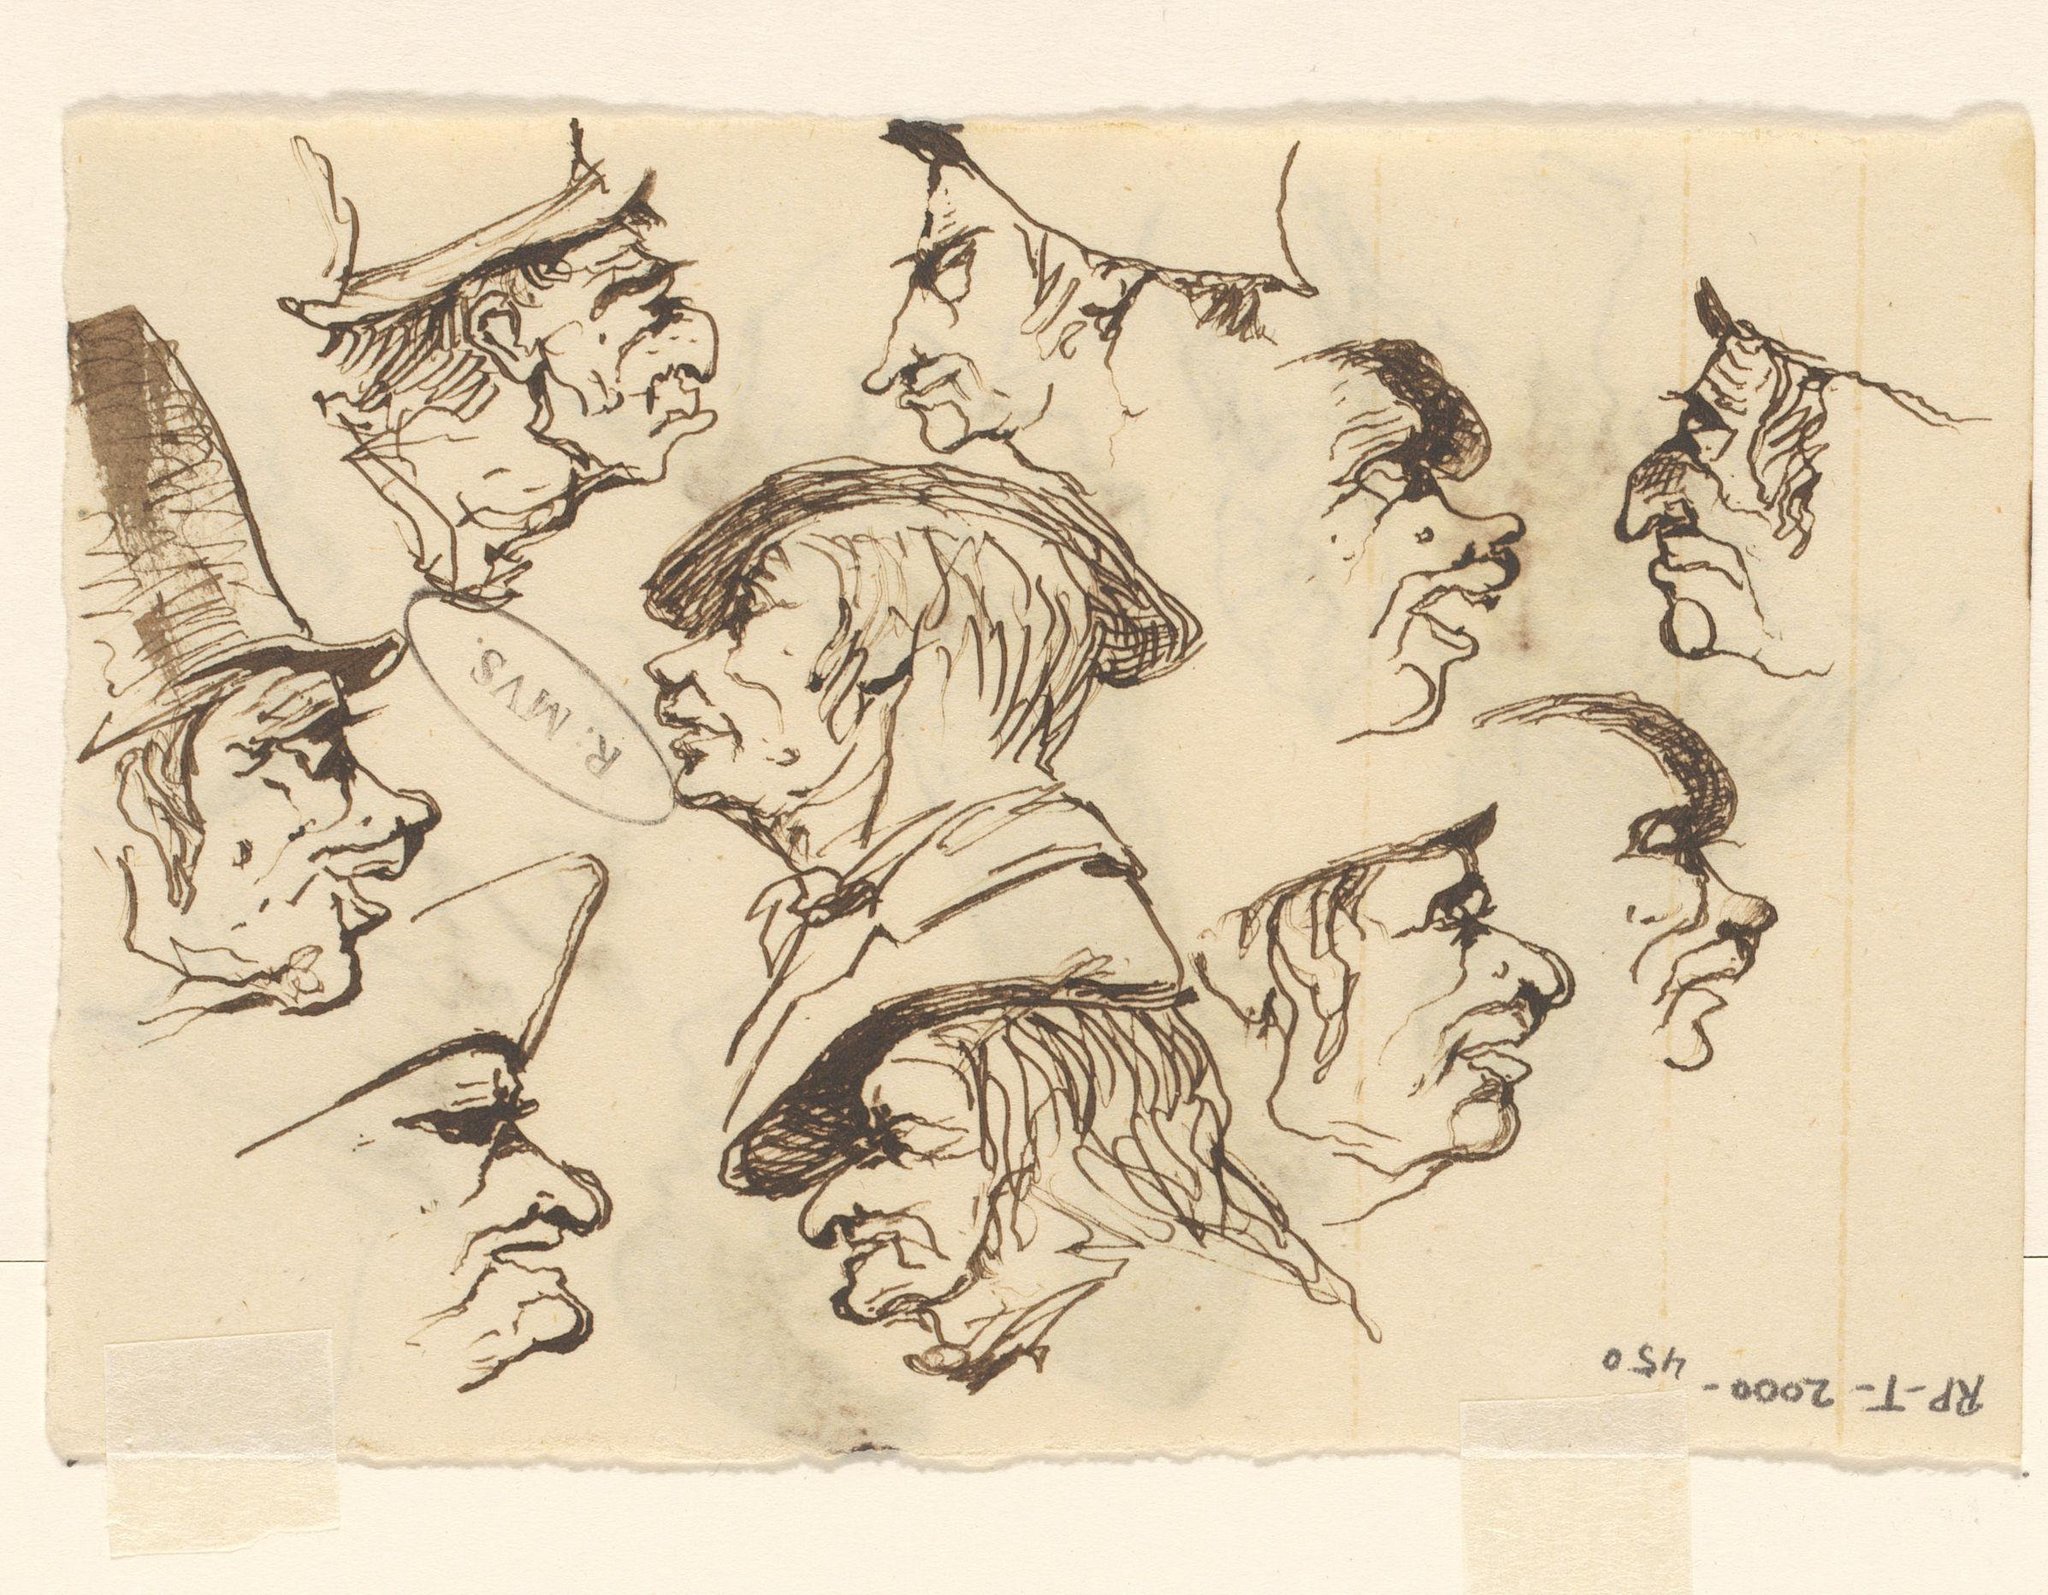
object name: drawing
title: Blad met koppen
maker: johannes tavenraat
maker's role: draughtsman, painter, print maker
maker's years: 1809-1881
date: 1840-1880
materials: ink, paper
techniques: pen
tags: caricatures (human types)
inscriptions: collector's mark: Lugt 2228